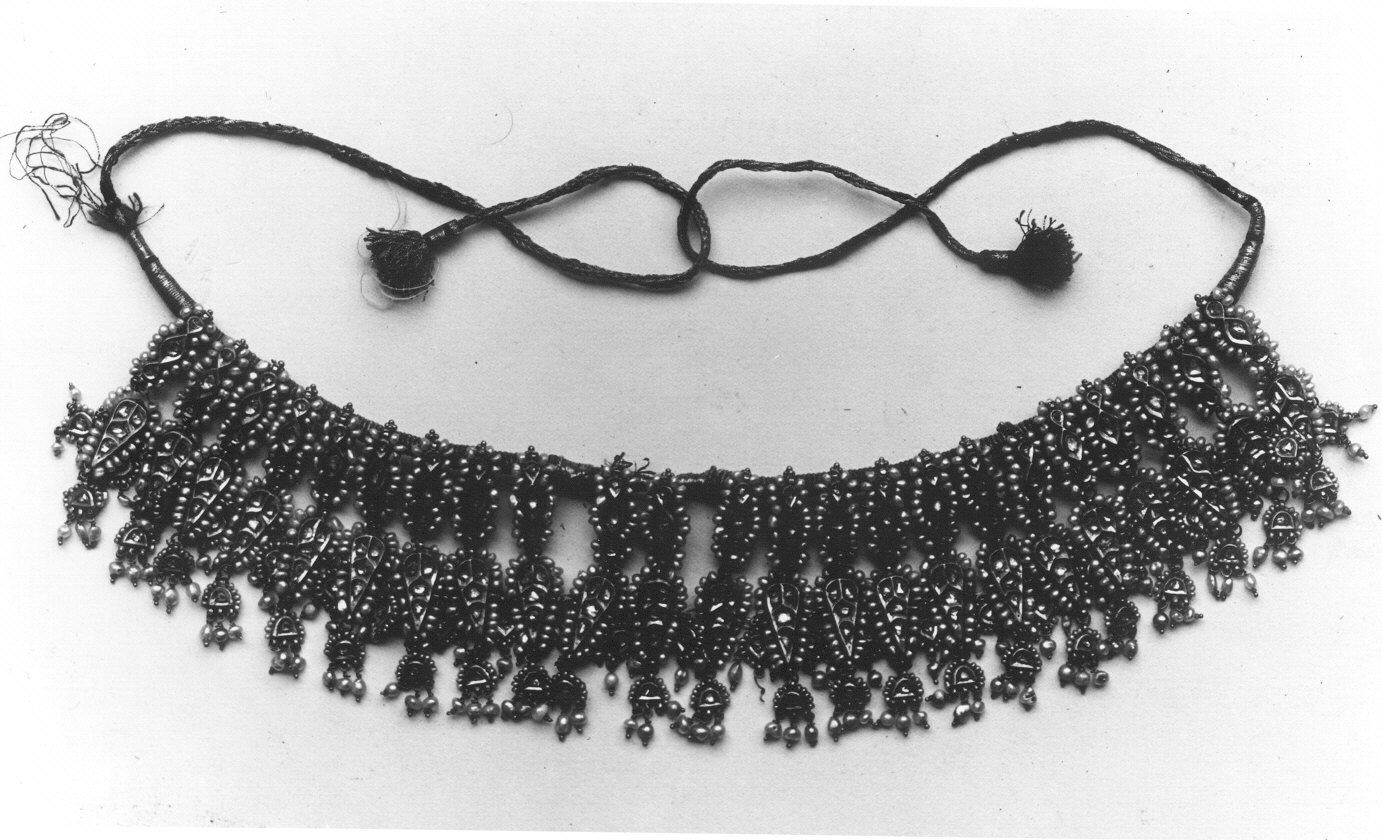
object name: necklace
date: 1701-1800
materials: gold, lacquer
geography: india